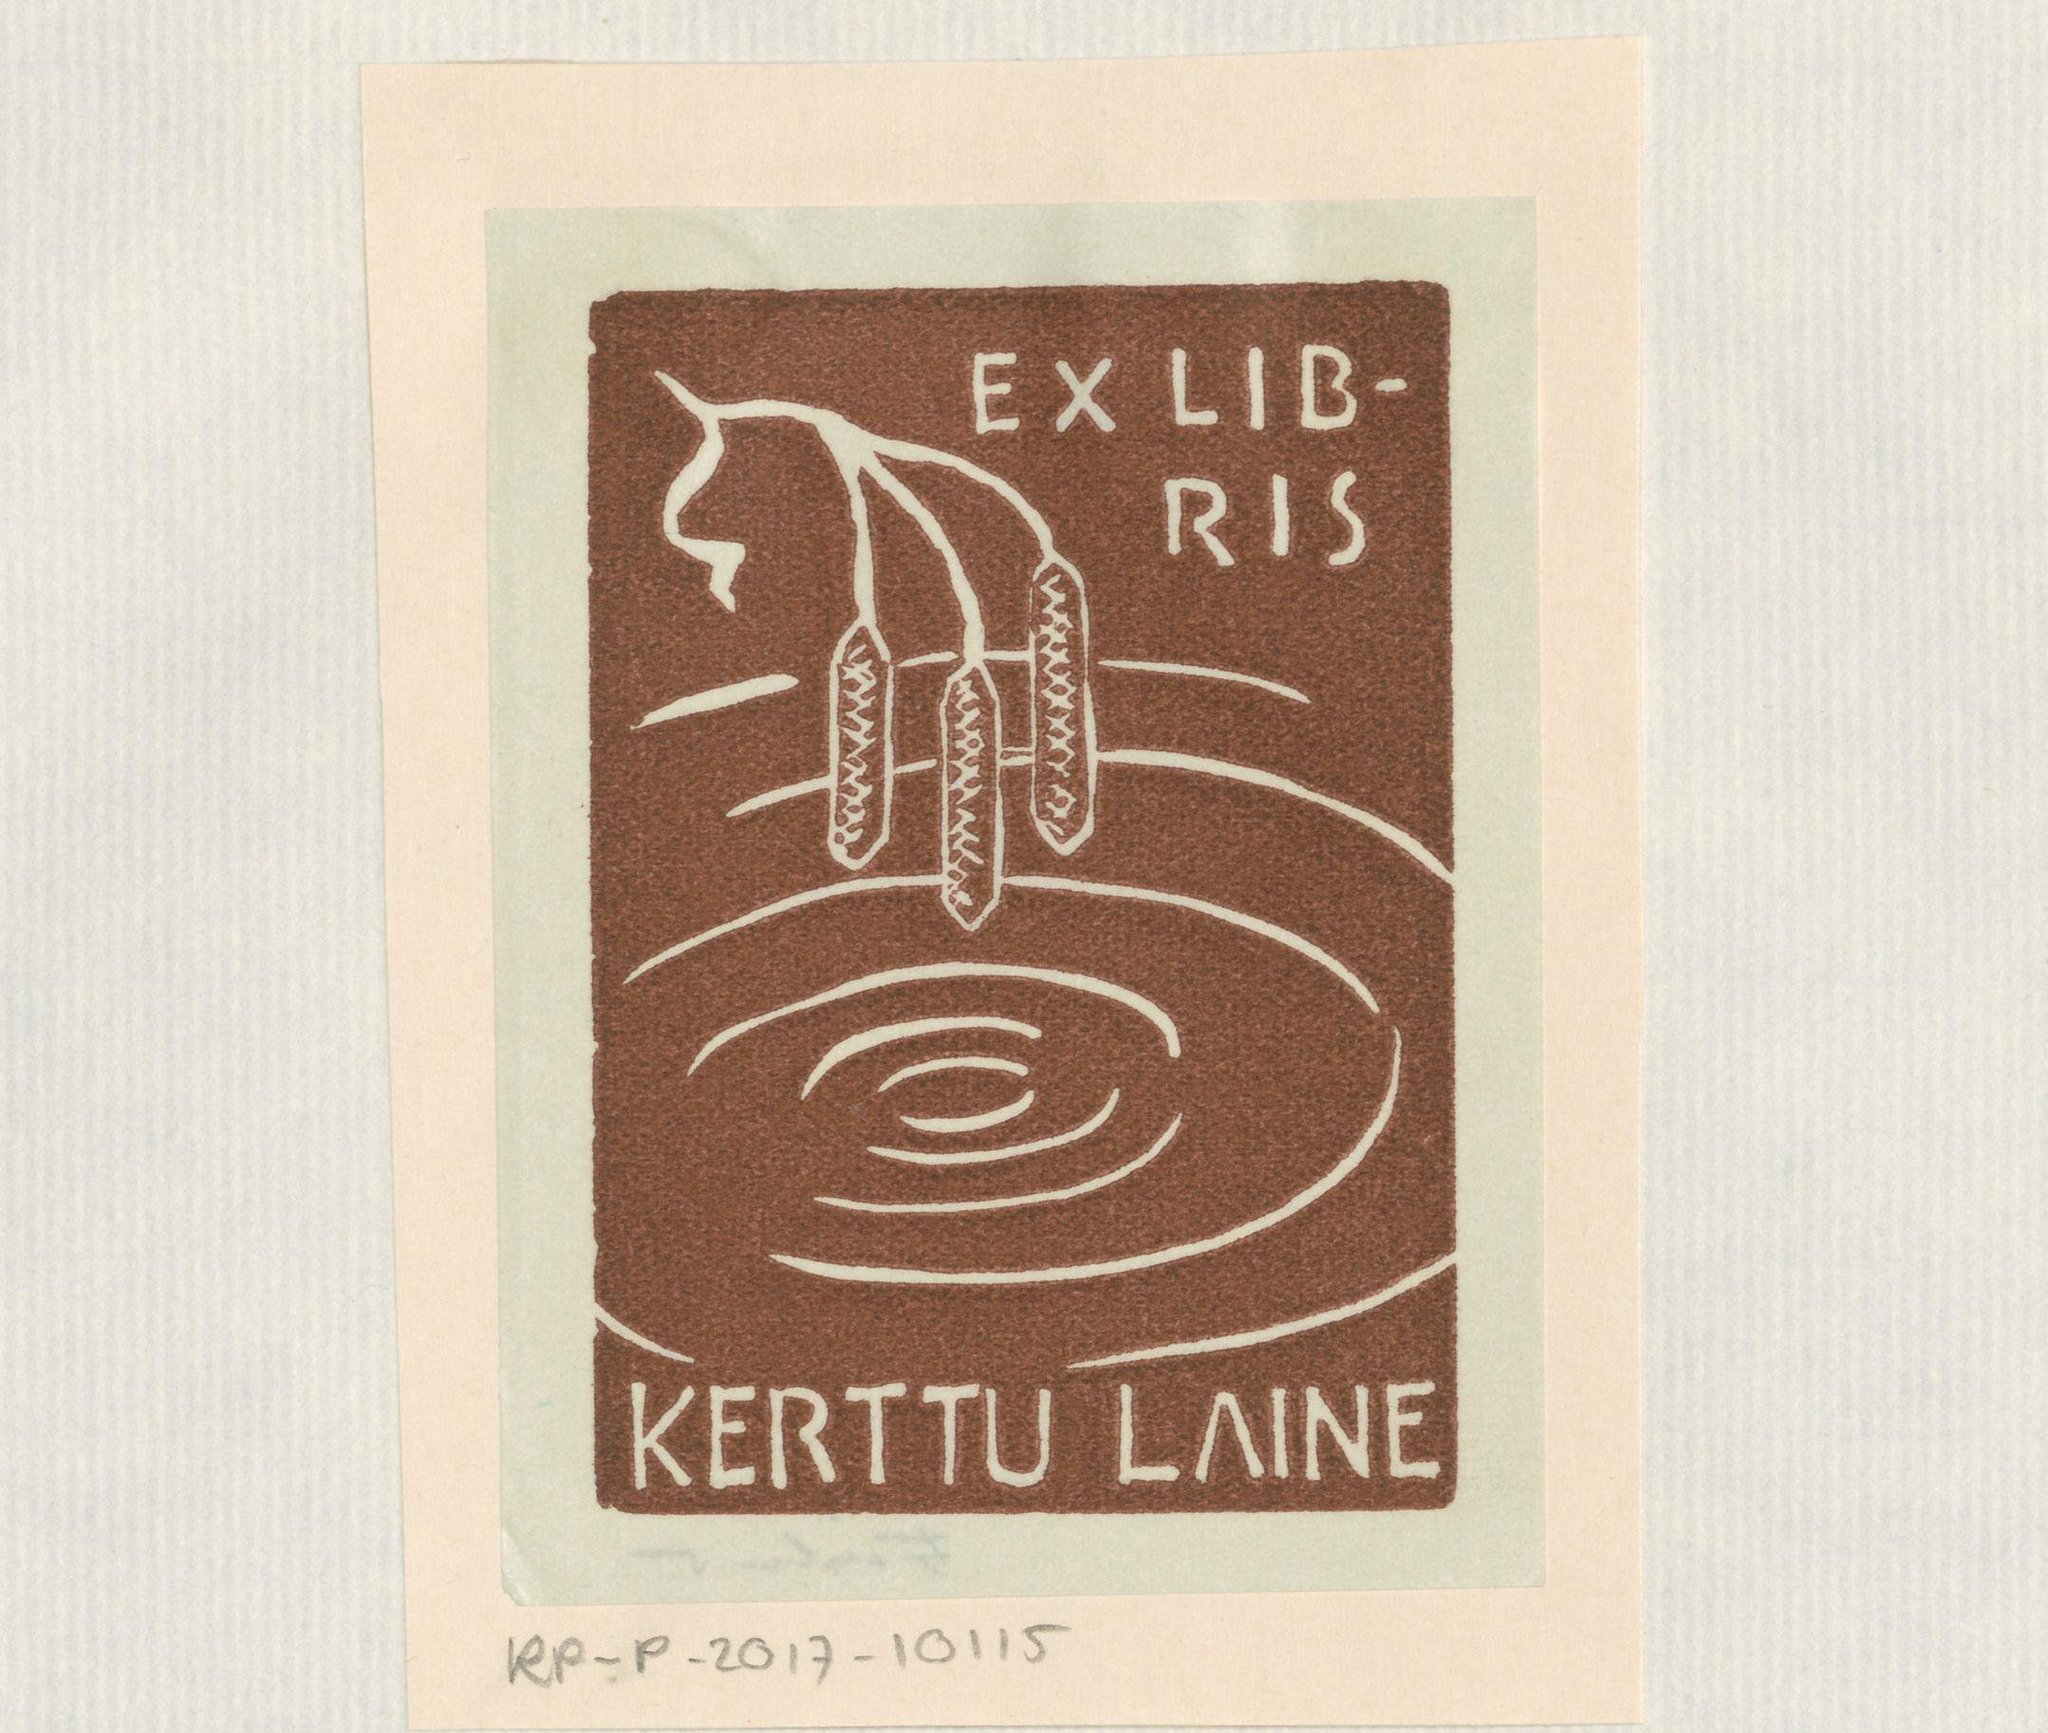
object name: bookplate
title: Ex libris van Kerttu Laine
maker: pekka törmä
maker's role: print maker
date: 1941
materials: paper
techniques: linocut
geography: finland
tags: trees, pond, pool